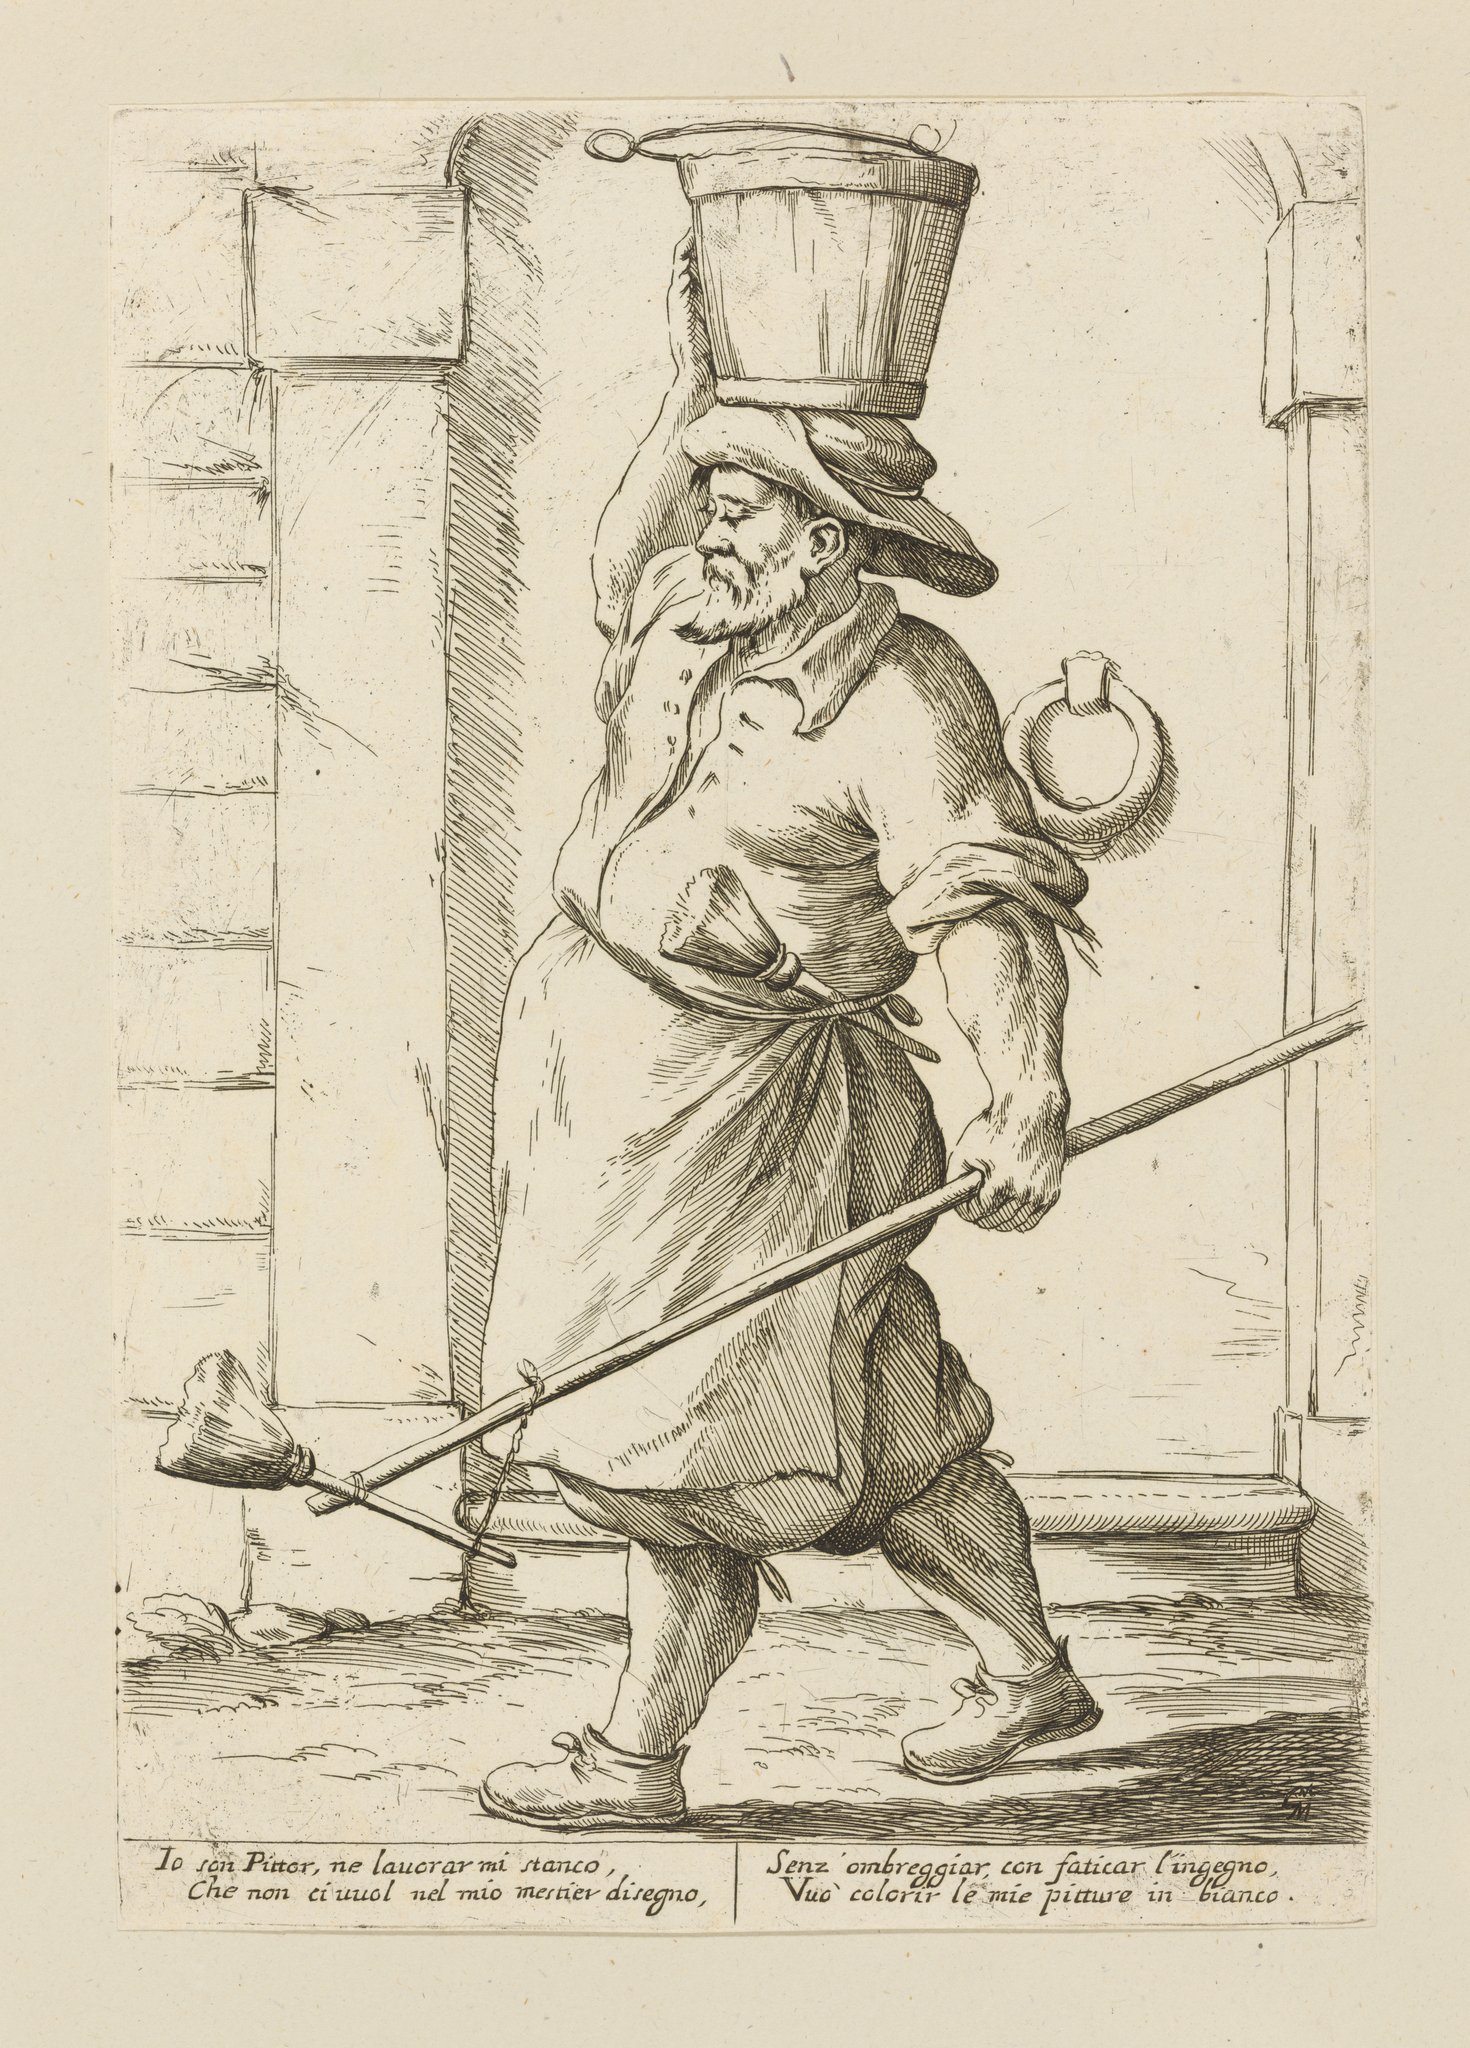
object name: print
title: Mason Going to Whitewash Walls, from Di Bologna l'Arti per via D'An.ibal' Ca.rac, plate 7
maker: giuseppe maria mitelli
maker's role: artist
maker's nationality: italian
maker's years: 1634-1718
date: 1660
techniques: etching